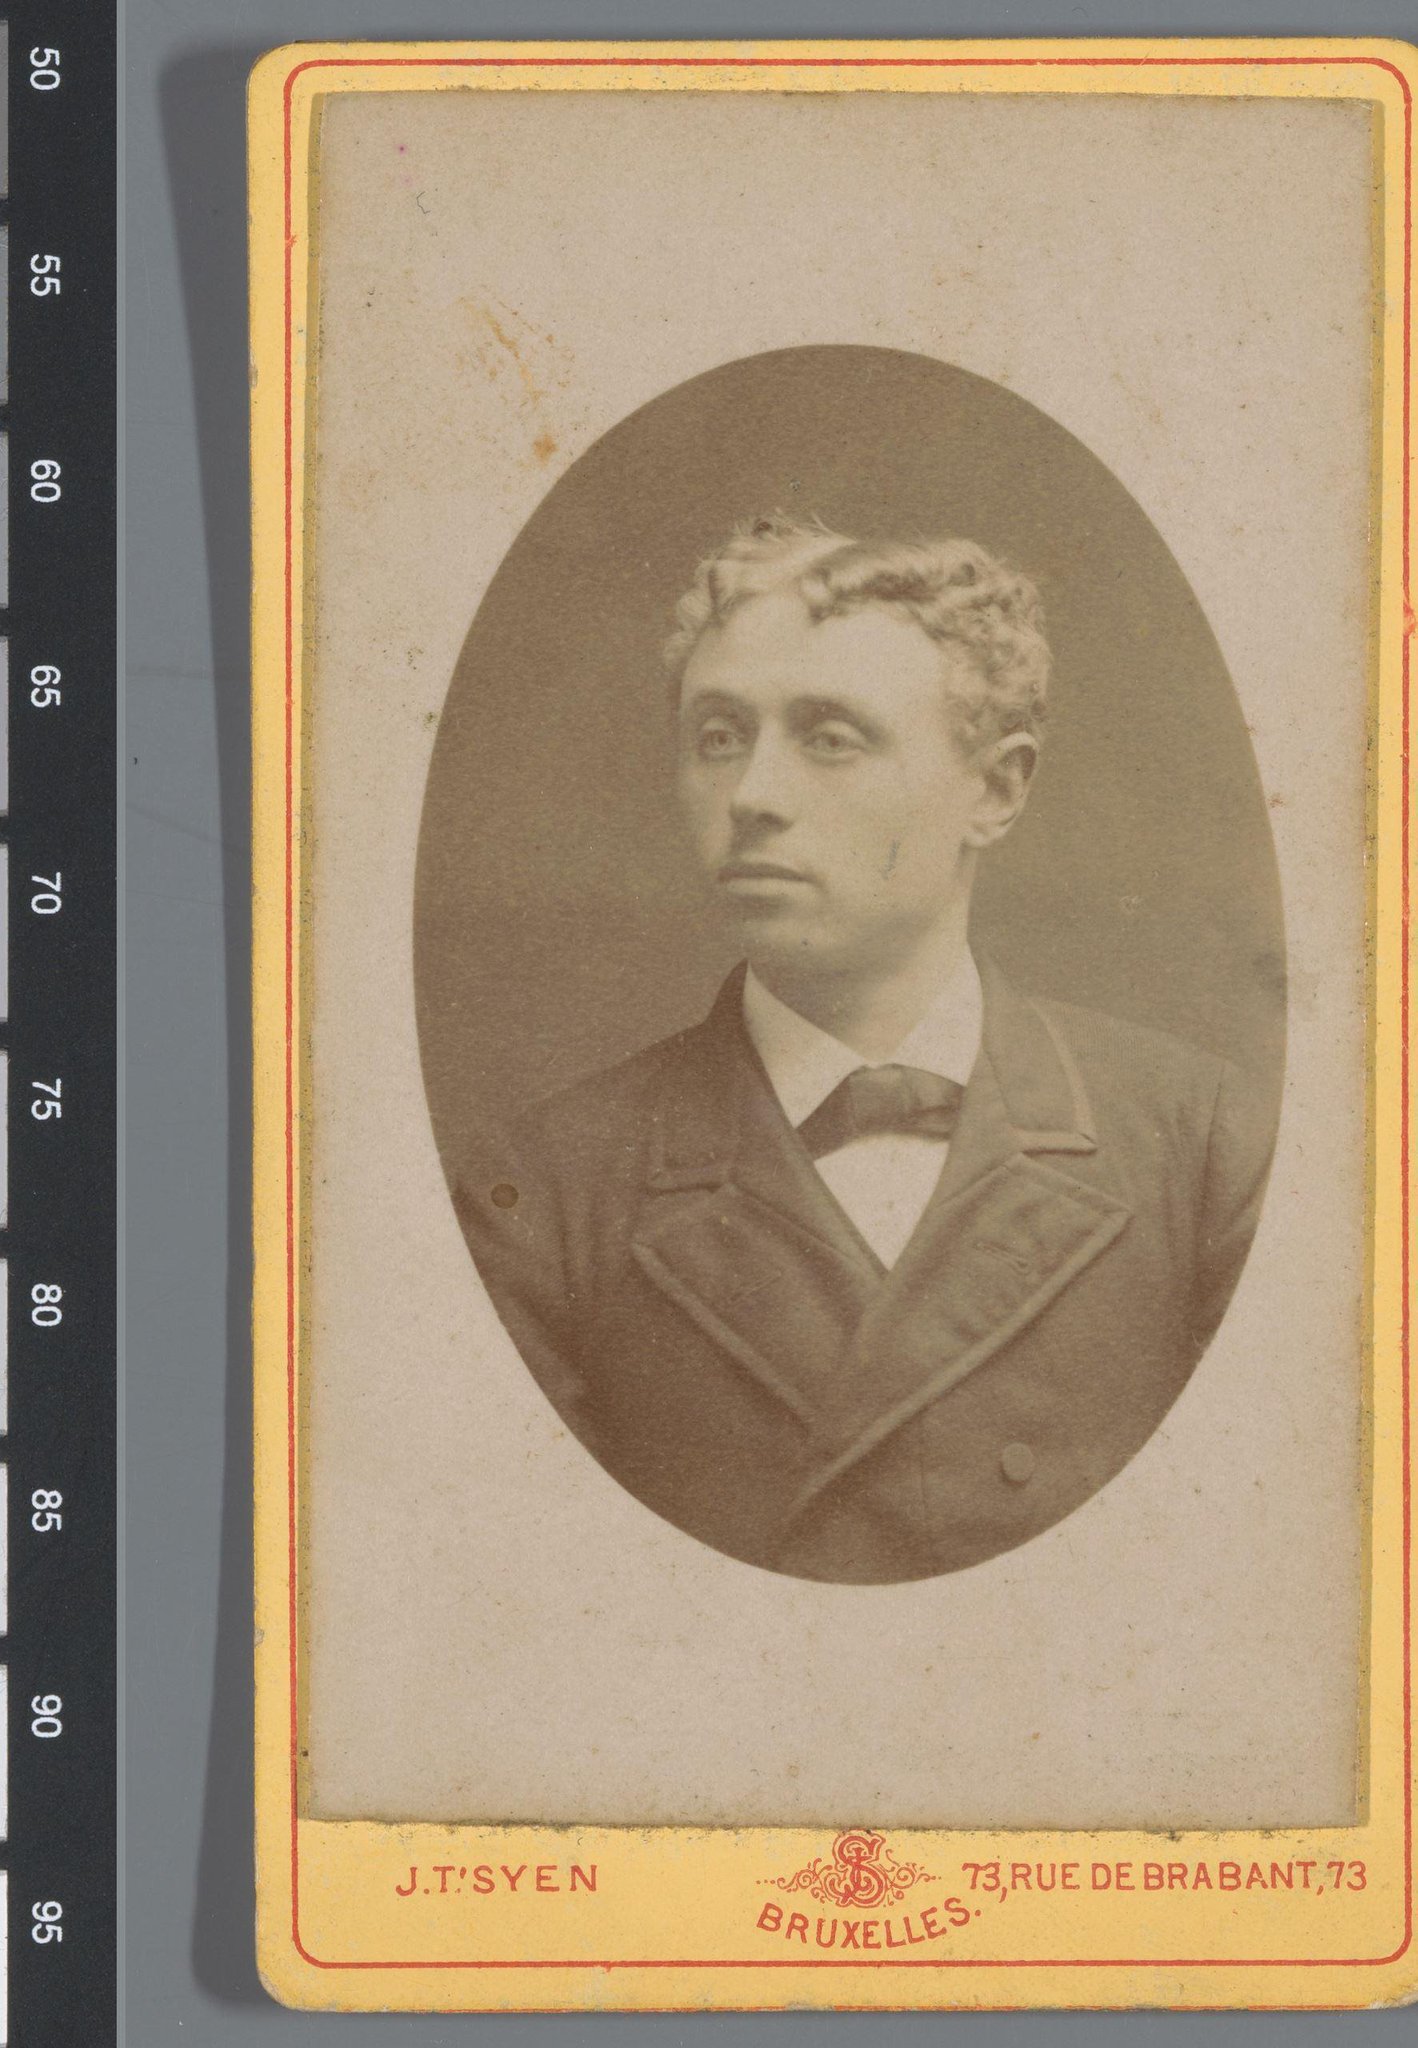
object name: carte de visite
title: Portret van een onbekende jonge man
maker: jean tsyen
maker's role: fotograaf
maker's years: 1843-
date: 1884-1885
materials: cardboard, celluloid, paper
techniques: albumen print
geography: brussels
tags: adult man, anonymous historical person portrayed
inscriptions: inscription: ‘Photographie/ Instantanée/ Les Clichés sont conservés.’, address: ‘73, Rue de Brabant, 73/ (GARE DU NORD)/ Bruxelles’